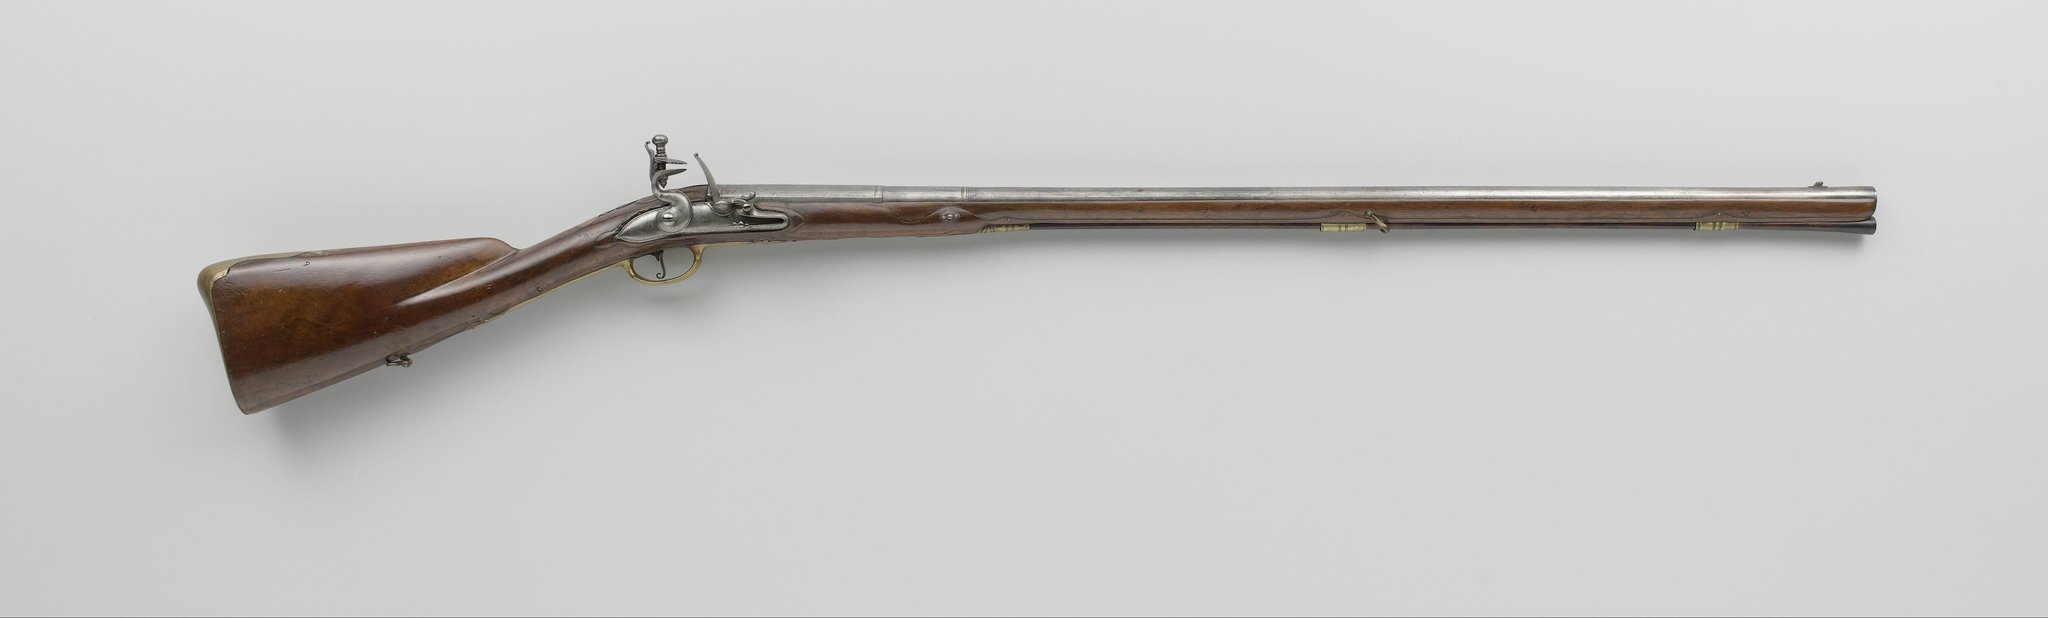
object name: jachtgeweer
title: Vuursteenjachtgeweer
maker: barend penterman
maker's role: geweermaker, pistoolmaker, vuursteenslotmaker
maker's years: -1723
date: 1700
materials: brass, horn, iron, silver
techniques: printing, cutting, engraving, gilding, striking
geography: utrecht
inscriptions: town mark, signature: ‘PENTERMAN // UTRECHT’, signature: ‘PENTERMAN // VTRECHT’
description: Op het slot staat een signatuur. De loop heeft een zilveren korrel en is voorzien van een stempel met het stadskeur van Utrecht en een signatuur. De kolf heeft eenvoudig snijwerk, gedeeltelijk in hoog-reliëf. Het geelkoperen beslag vertoont sporen van vroeger verguldsel en bestaat onder meer uit: drie laadstokkokers, een S-vormige schroefplaat met twee tegengestelde bladerranken in het midden, een onbewerkte duimplaat versierd met lofwerk, een kolfplaat die eindigt in een langgerekt blad en een laadstok voorzien van een koehoornen kap; bij de middelste laadstok zit een ijzeren scharnierende beugel, achter de trekkerbeugel een geelkoperen.